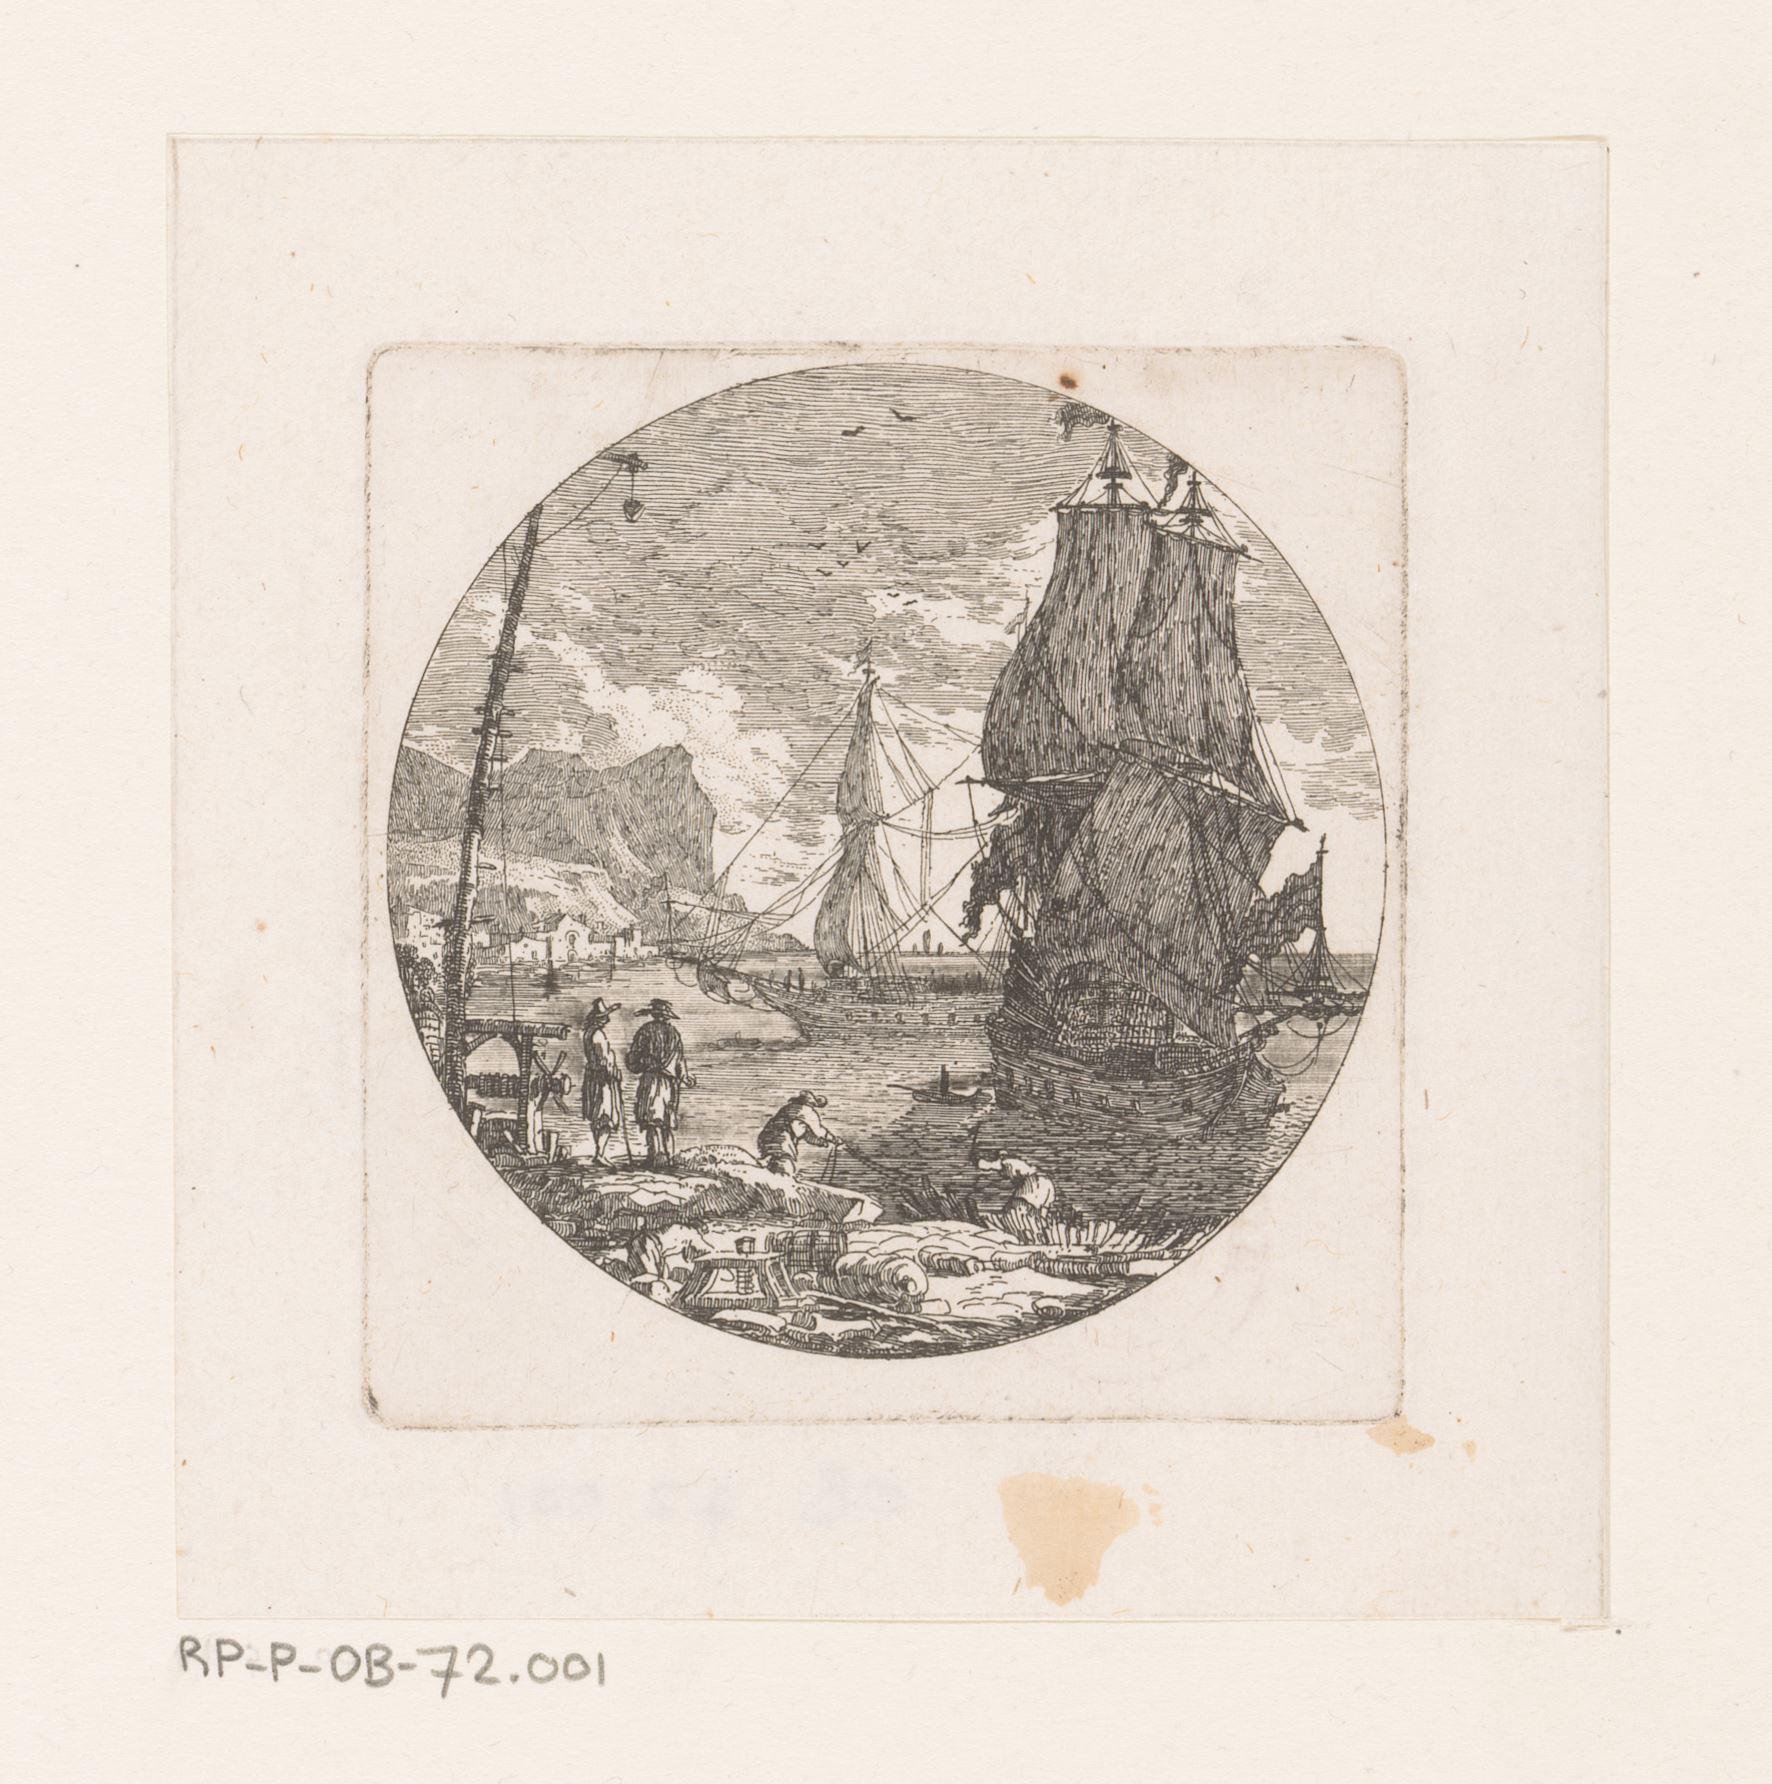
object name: print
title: Kustgezicht met schepen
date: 1613-1695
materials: paper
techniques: etching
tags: harbour, coast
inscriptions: collector's mark: Lugt 240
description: Prenten met het signatuur 'Perelle' kunnen zowel door vader Gabriel als door zonen Nicolas en Adam gemaakt zijn.